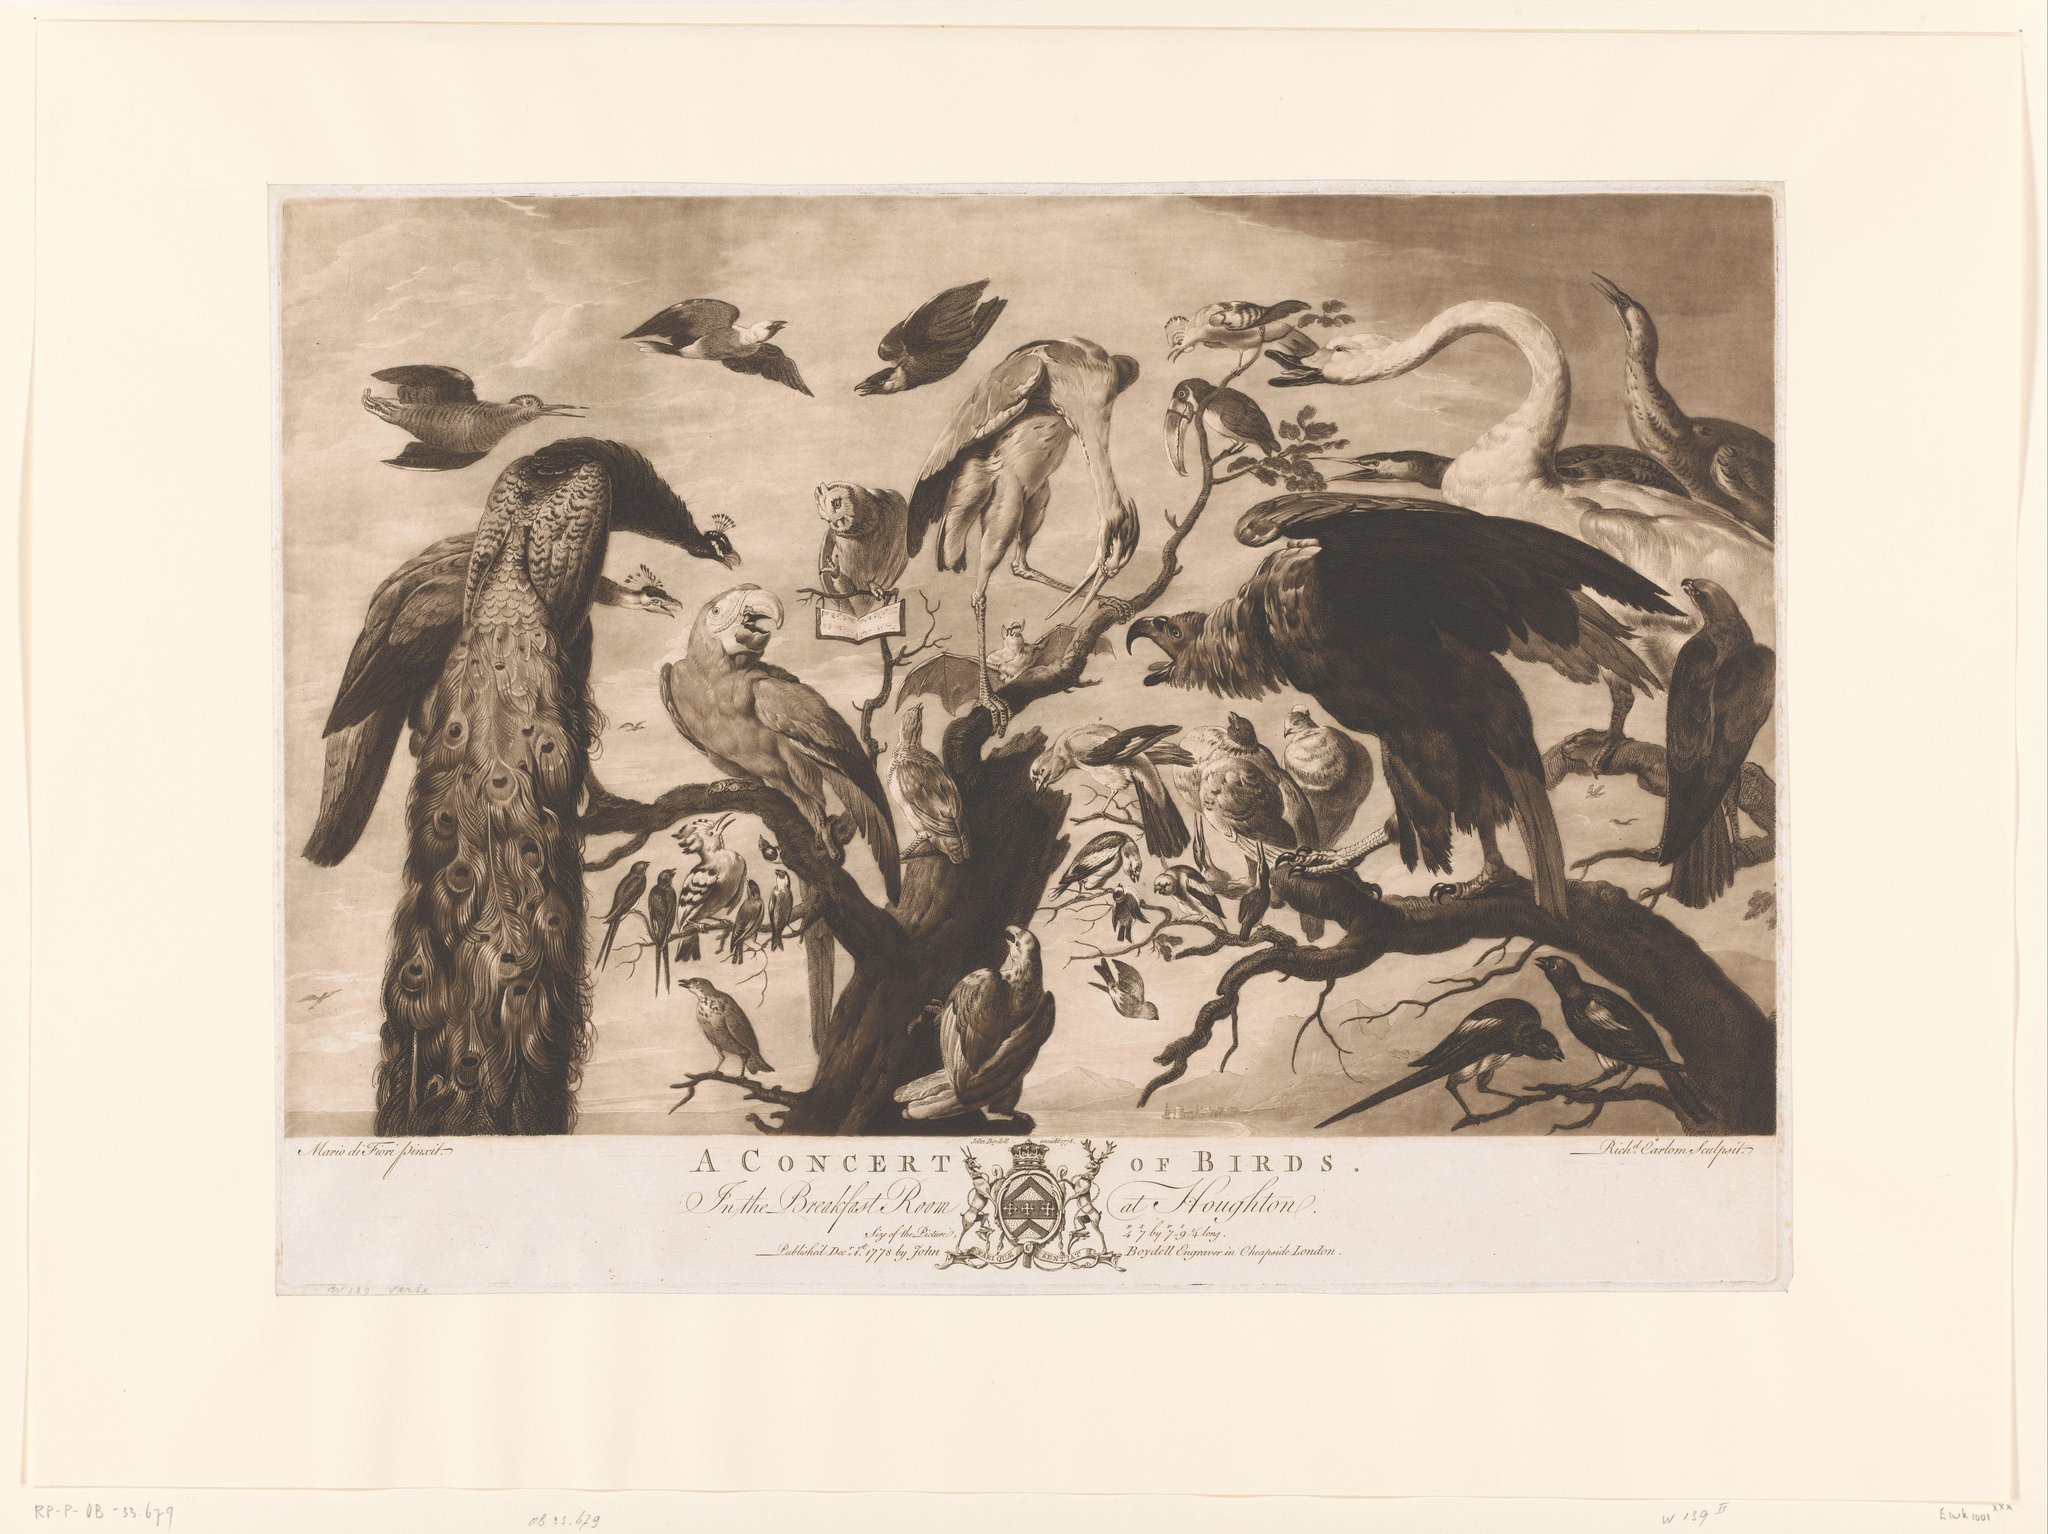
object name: print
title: Allerlei soorten zingende vogels onder leiding van een uil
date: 1778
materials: paper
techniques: etching, roulette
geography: london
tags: birds, animals acting as human beings, more than one musician with instrument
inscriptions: collector's mark: Lugt 240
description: Papegaaien, pauwen, een havik, een adelaar, zangvogels, een zwaan, een toekan, een gaai, een grutto, hoppen, kraaien, eksters, een vleermuis, zwaluwen, mussen, duiven en meer.